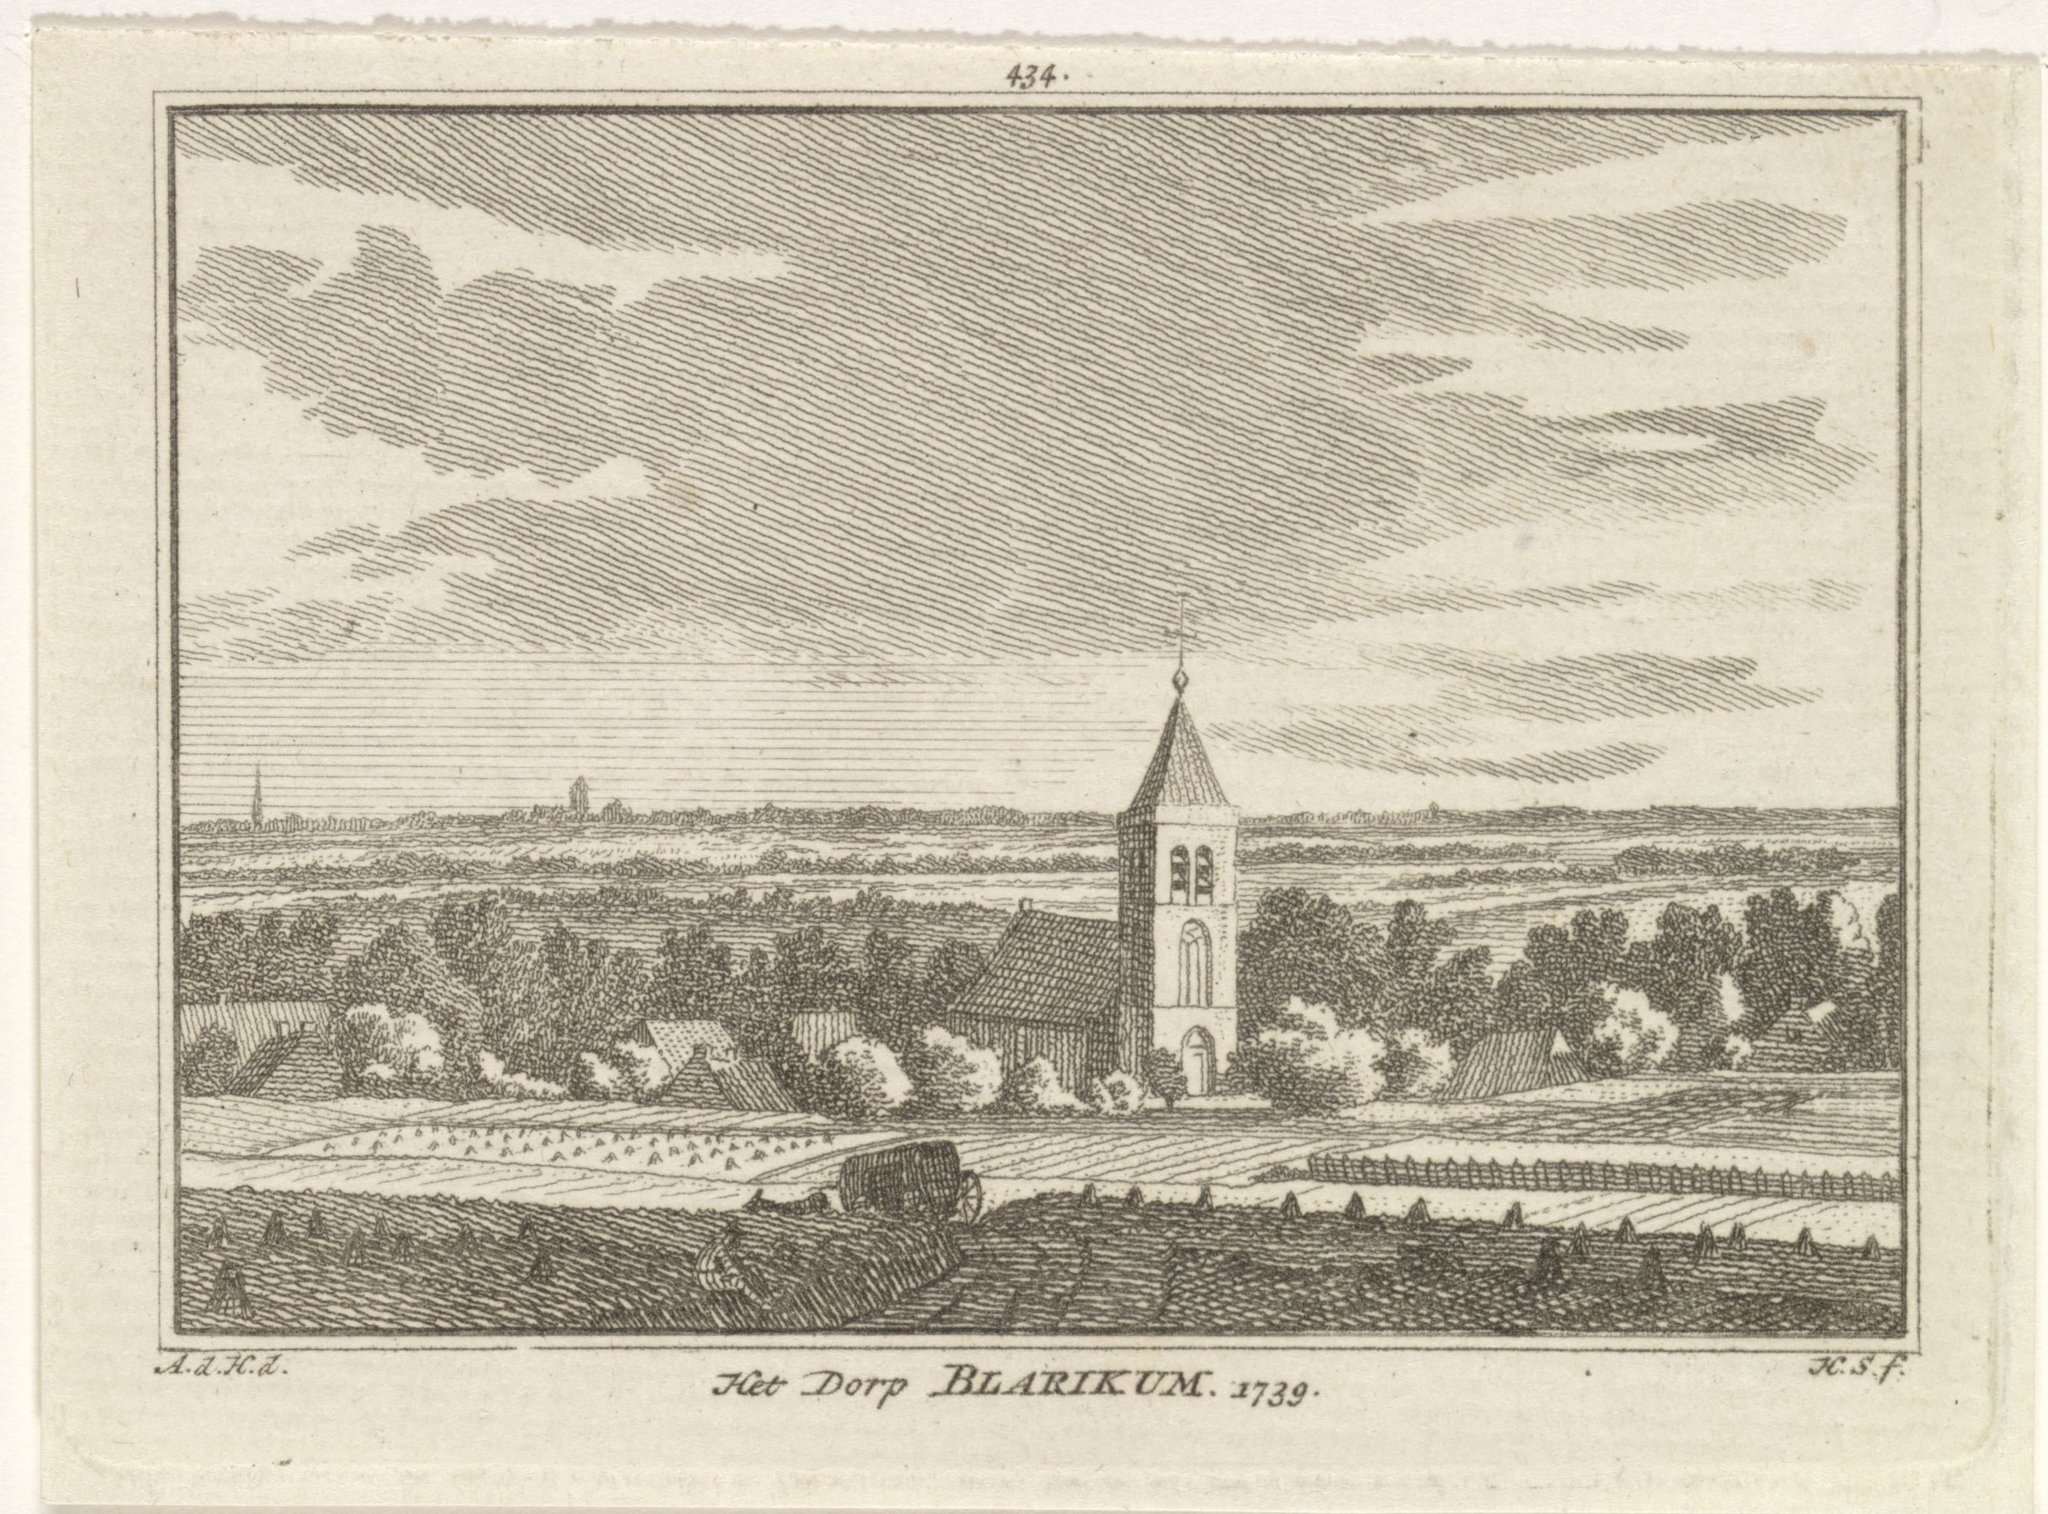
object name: book illustration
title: De Dorp Blarikum. 1739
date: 1757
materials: paper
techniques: etching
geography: haarlem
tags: church (exterior)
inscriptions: collector's mark: Lugt 2228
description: Prent gebruikt in: Het verheerlykt Nederland of kabinet van hedendaagsche gezigten van steden, dorpen, sloten ... en andere voornaame stad- en landgebouwen, in en omtrent alle de byzondere Vereenigde Nederlandsche Provinciën : gedurende de laatste jaaren door vermaarden kunsttekenaren na het leven getekent en ... in 't koper gebragt ... dienende tot opheldering der beschryvinge van den Tegenwoordigen Staat der Vereenigde Nederlanden. Deel VI, 1757. Amsterdam: Isaac Tirion, 1745-1774.